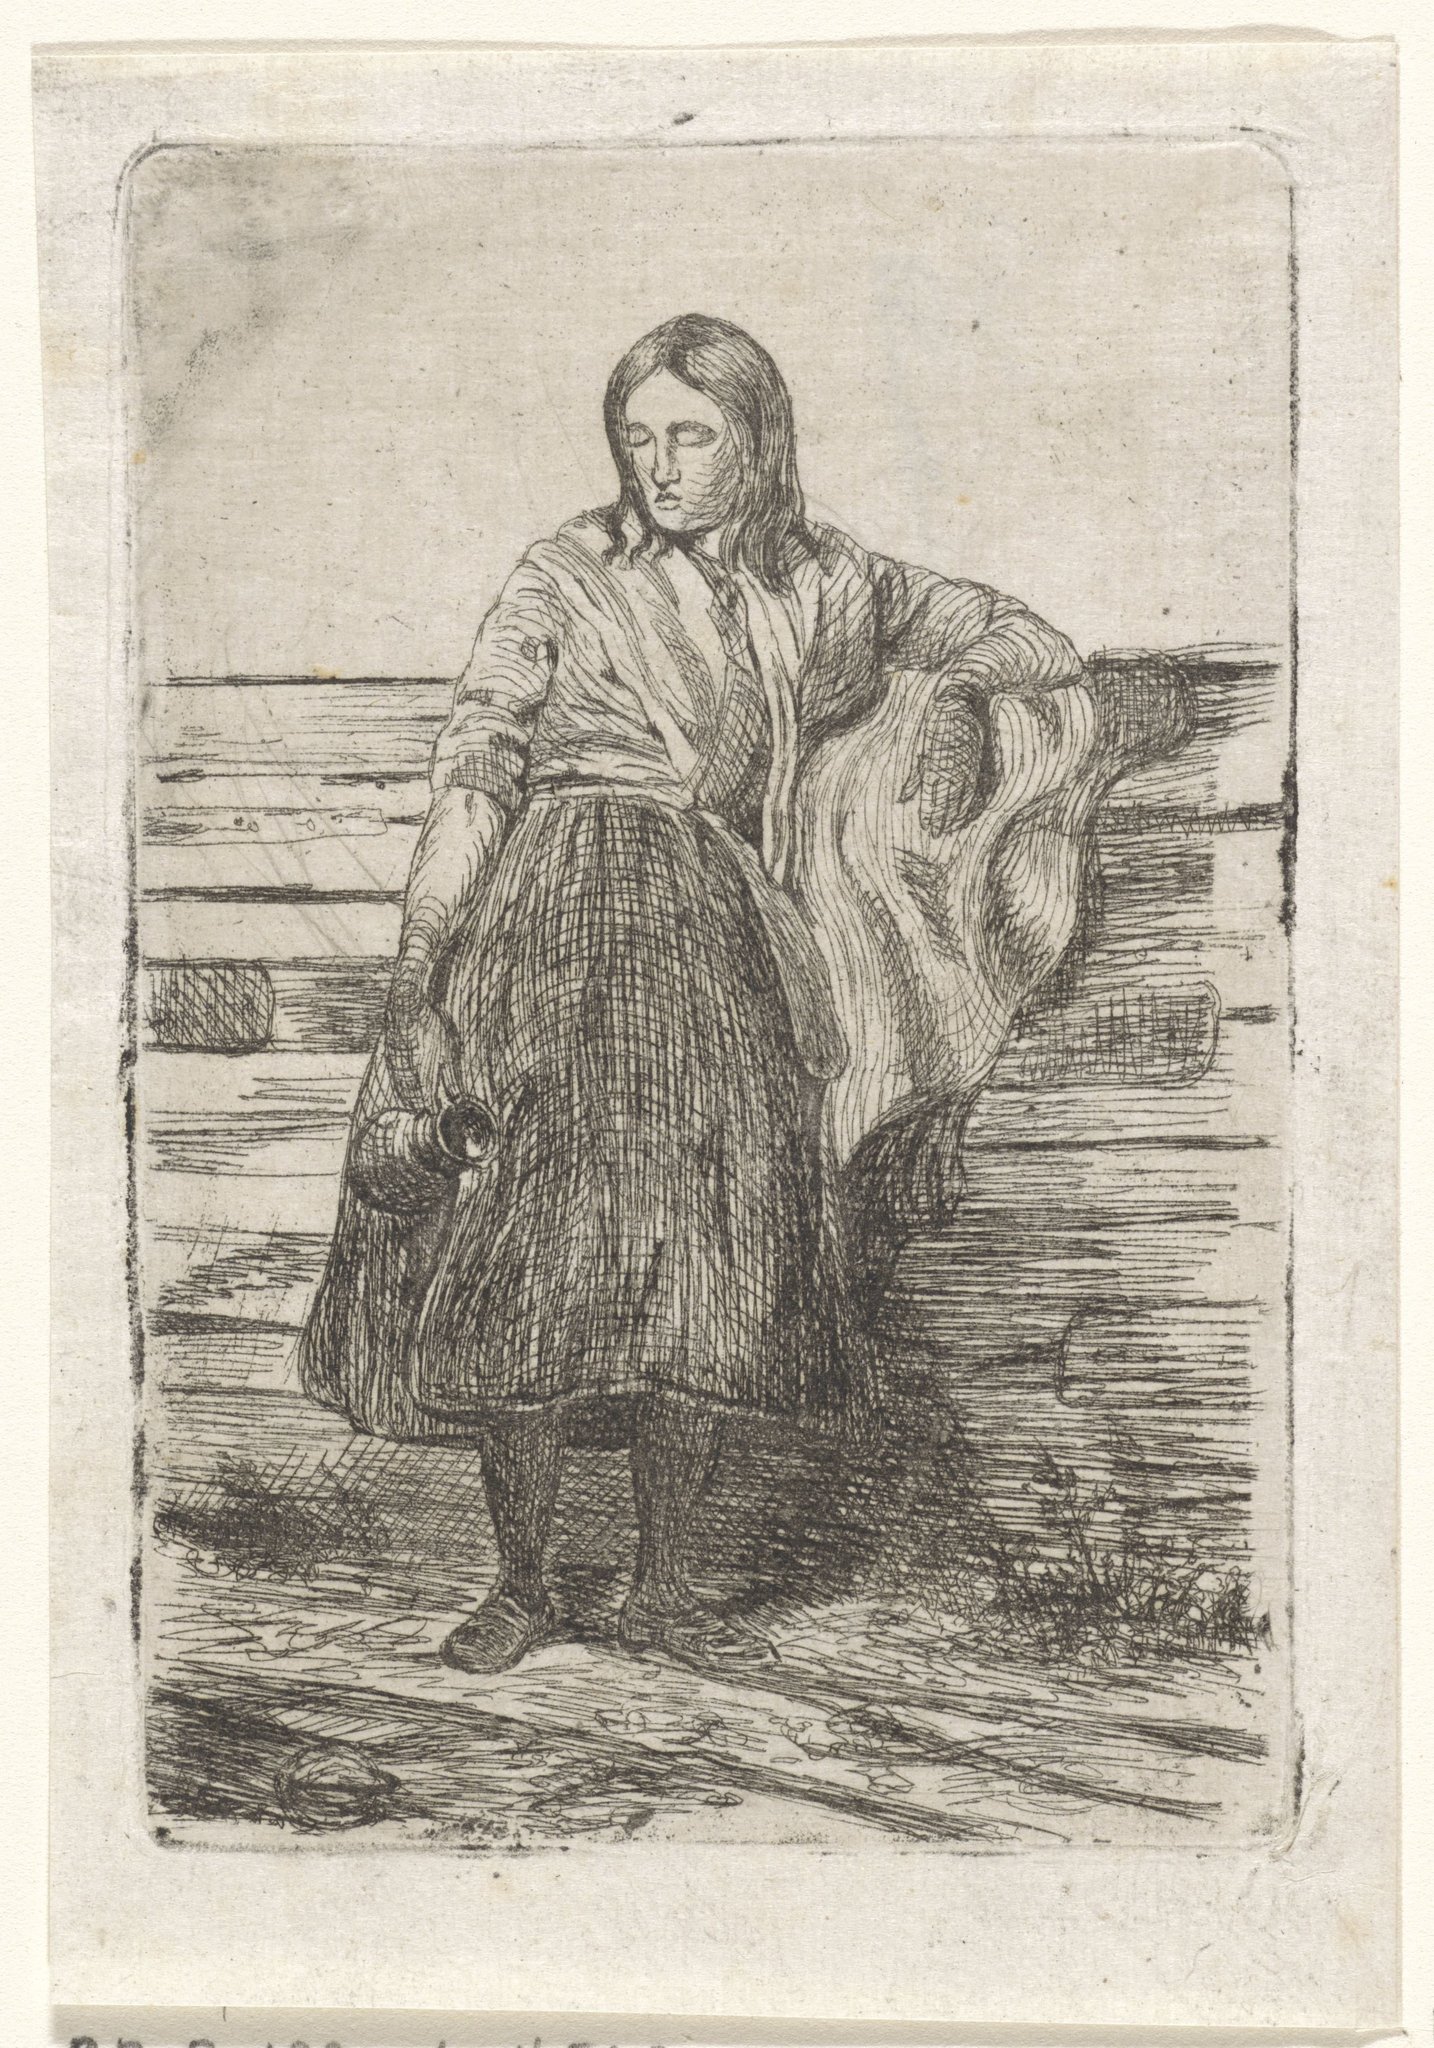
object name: print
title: Jonge vrouw bij een schutting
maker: frederik hendrik weissenbruch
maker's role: draughtsman, print maker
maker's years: 1828-1887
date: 1843-1887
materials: paper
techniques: etching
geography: the hague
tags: adolescent, young woman, maiden, fence, wall, paling, jar, jug (used as drinking-vessel)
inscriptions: collector's mark: Lugt 2228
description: Een jonge vrouw leunt met een arm op een schutting. In haar rechterhand houdt ze een kan.